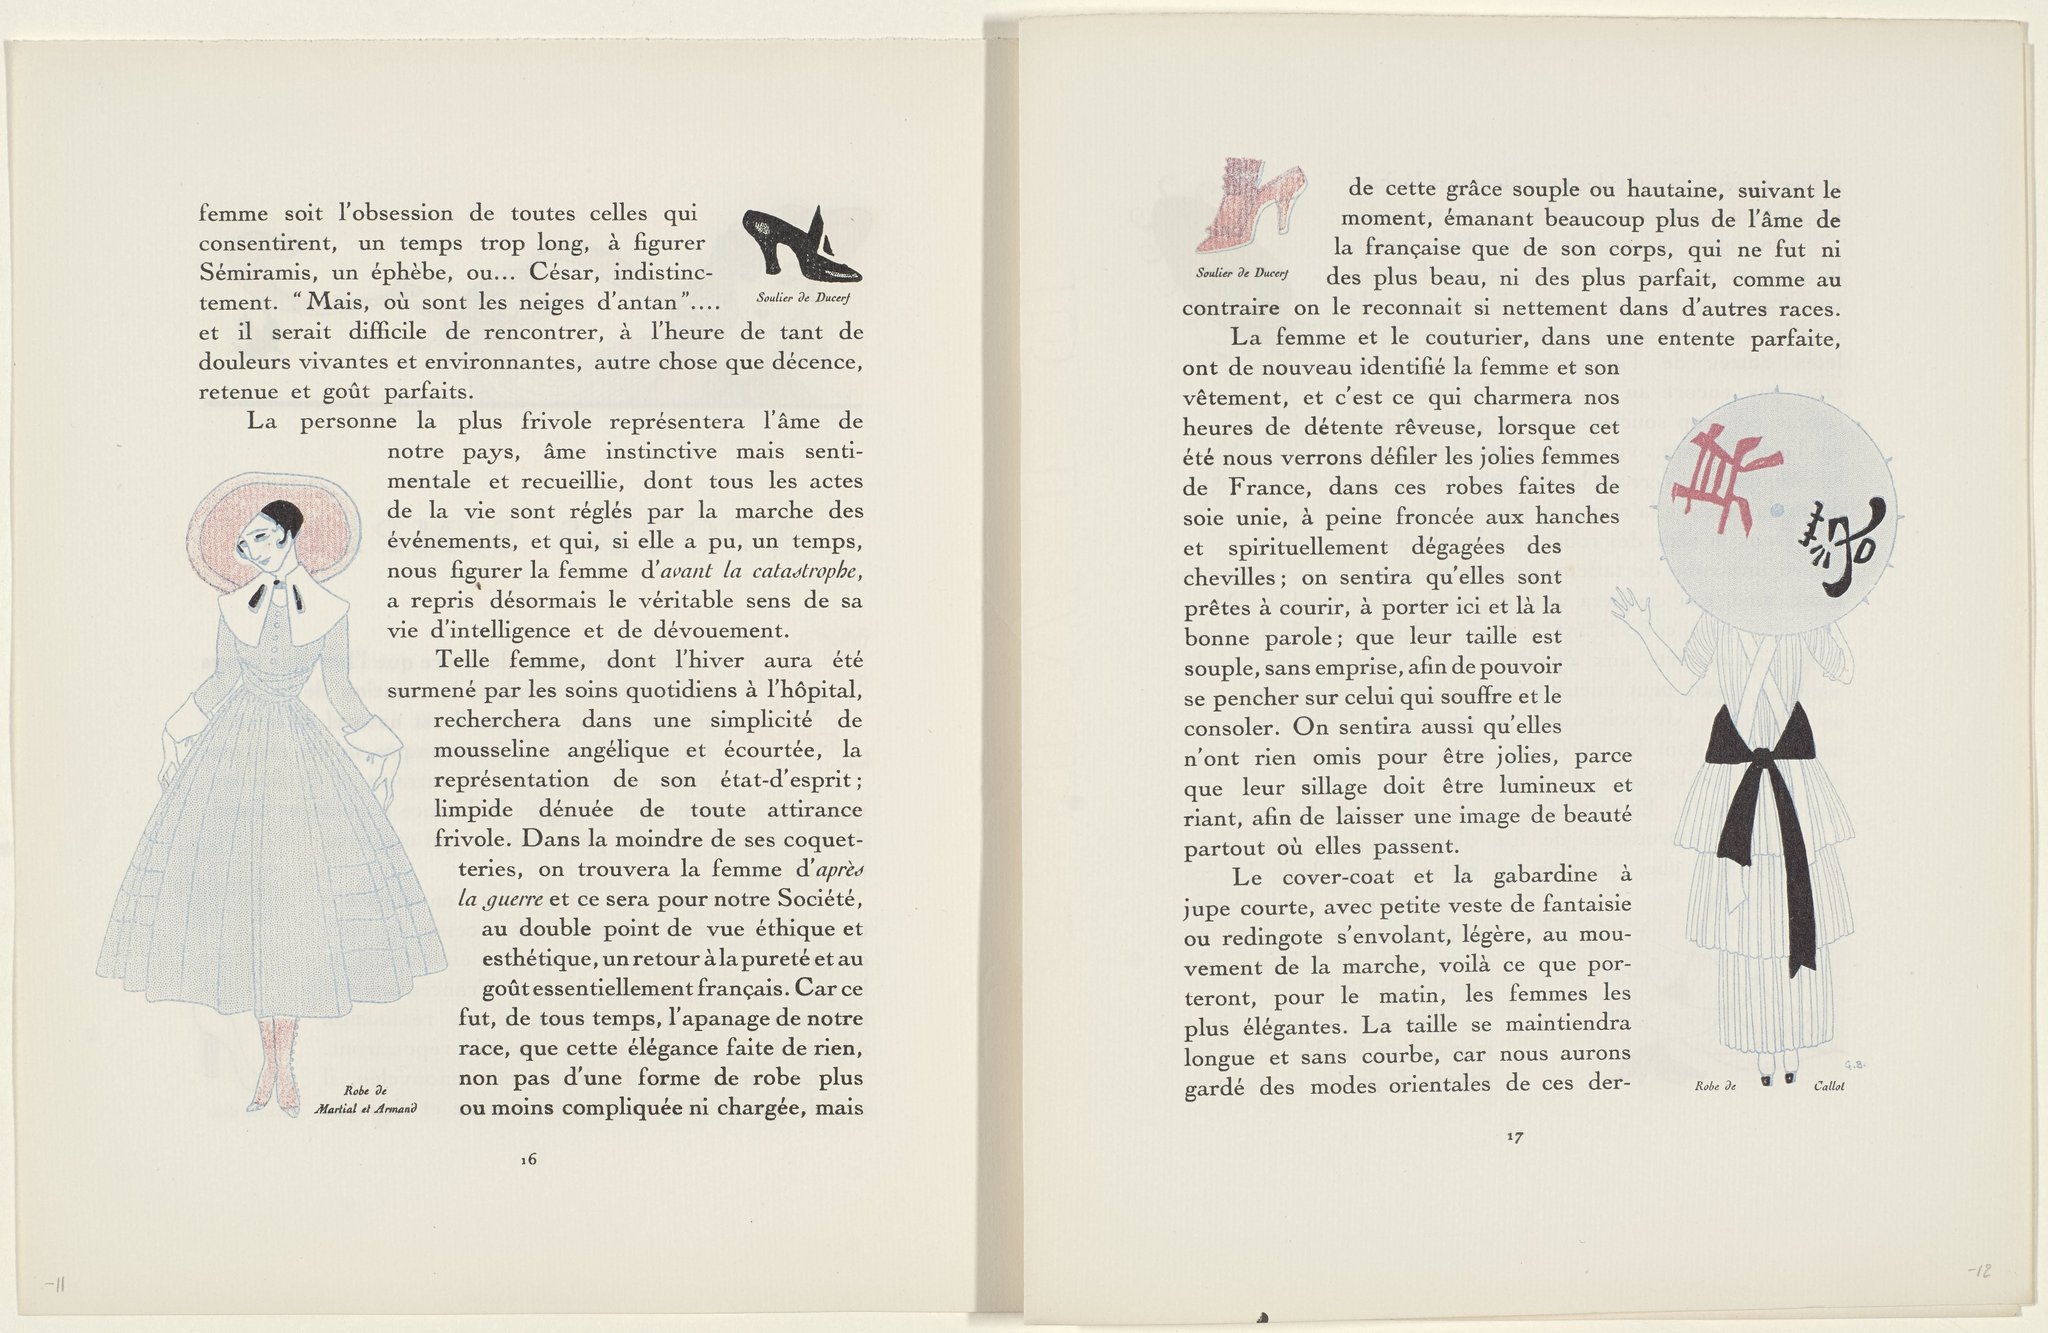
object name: fashion print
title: Gazette du Bon Ton, 1915 - No. 8-9, p. 17: Autours Simples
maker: lucien vogel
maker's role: publisher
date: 1915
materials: paper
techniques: hand coloring, letterpress printing, photochemical processes, pochoir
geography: london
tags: fashion plates, shoes, sandals (+ women's clothes), dress, gown (+ women's clothes)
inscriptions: date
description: Gazette du Bon Ton 1915, No. 8-9, pag. 17: Tekst met illustratie: "Robe de Callot": vrouw op de rug gezien met japanse parasol. Linksboven een damesschoen van Ducerf